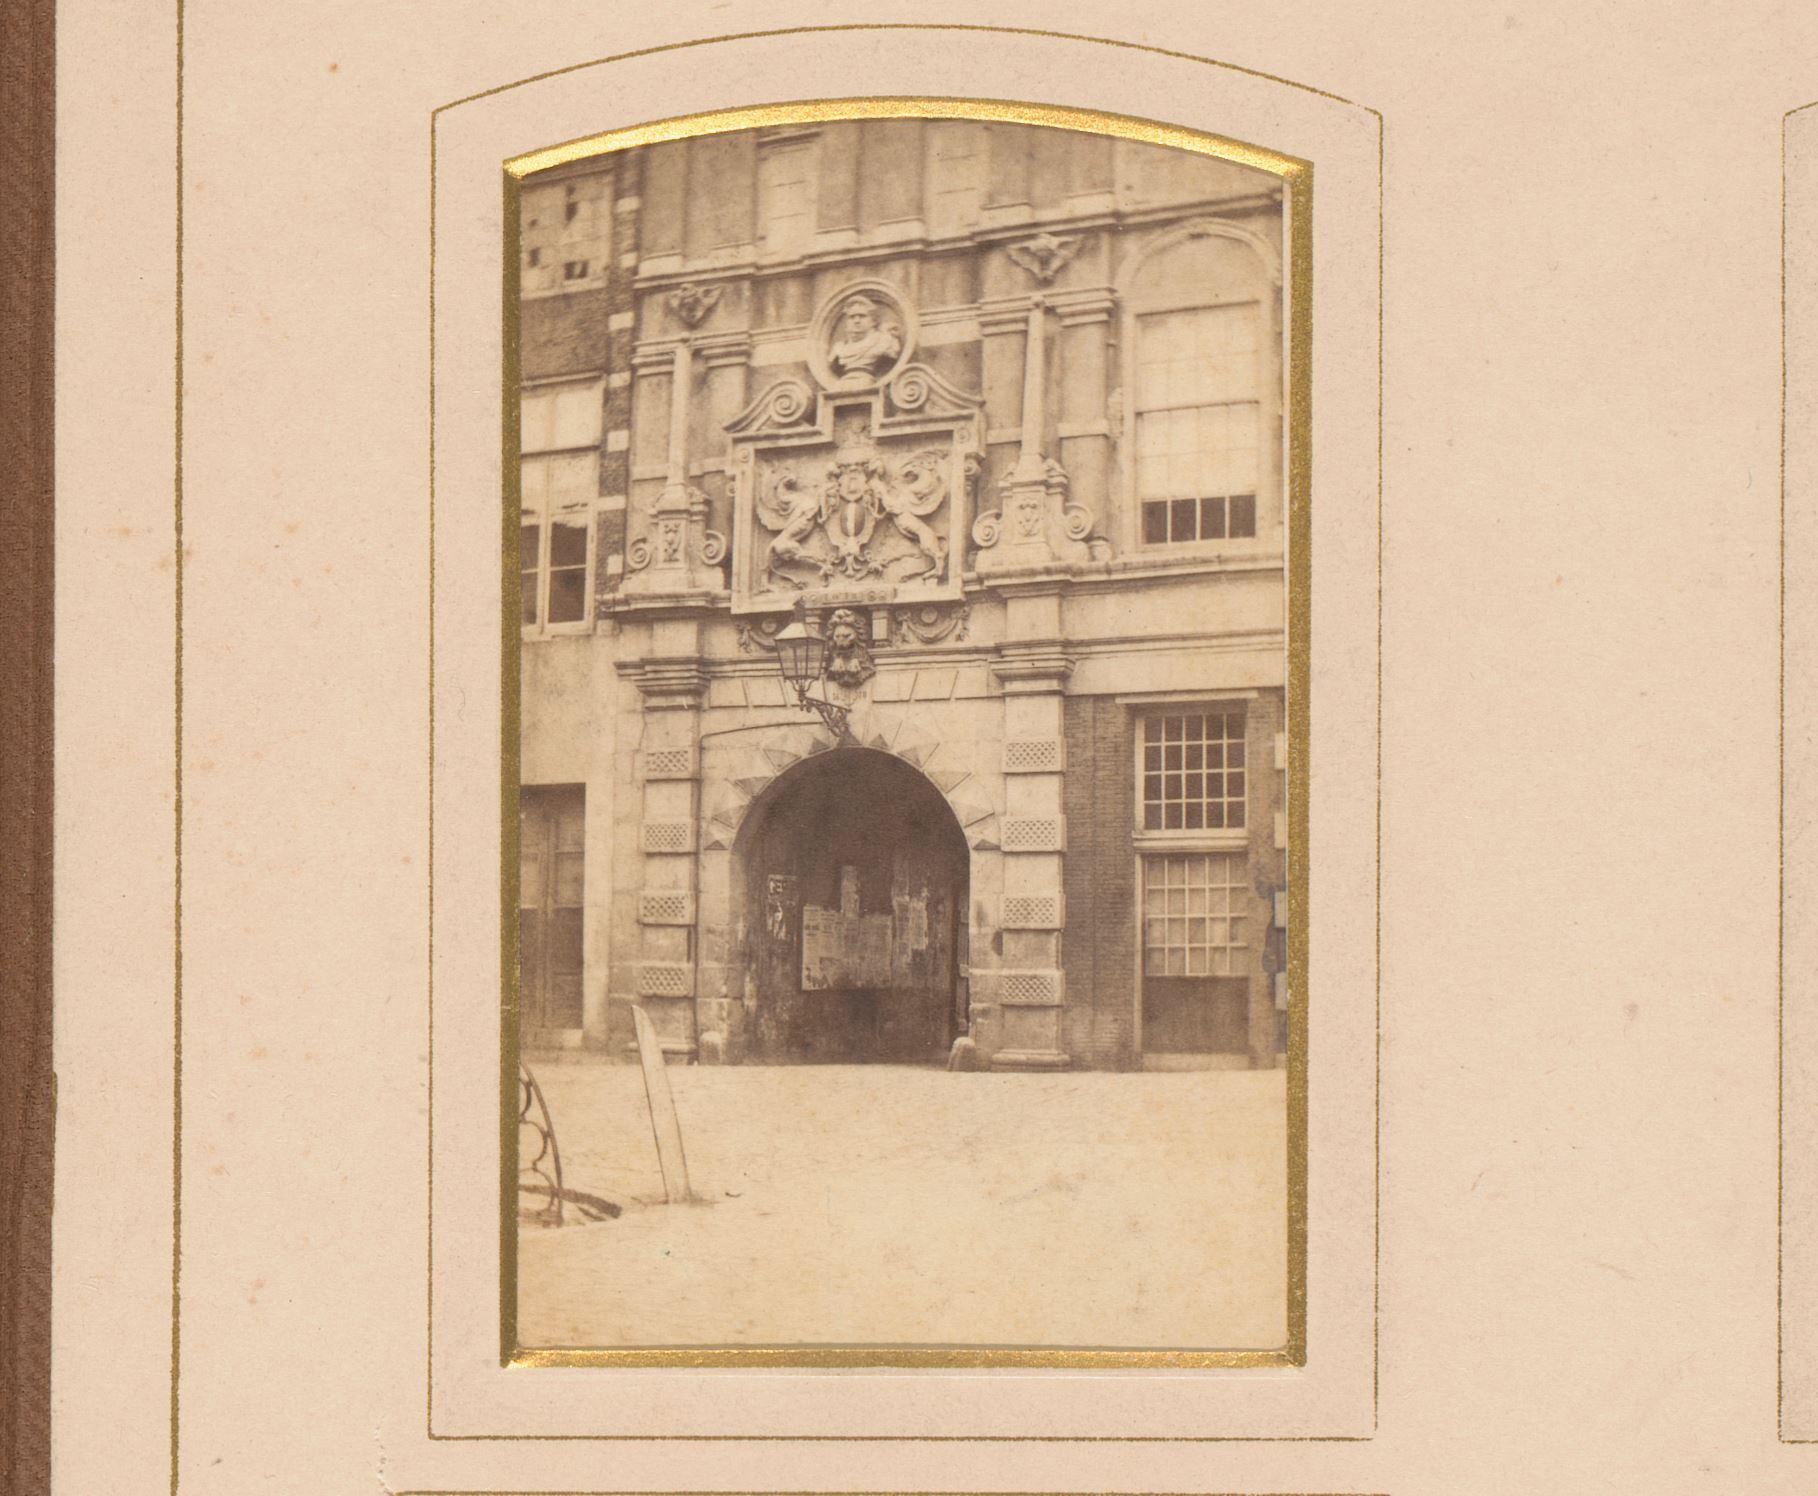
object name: album leaf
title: Gezicht op de Groothoofdspoort in Dordrecht, Zuid-Holland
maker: leendert de koningh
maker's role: draughtsman, print maker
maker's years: 1777-1849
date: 1865-1887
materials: cardboard, photographic support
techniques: albumen print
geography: dordrecht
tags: city-gate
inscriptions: inscription: ‘L. DE KONINGH/ DORDRECHT.’